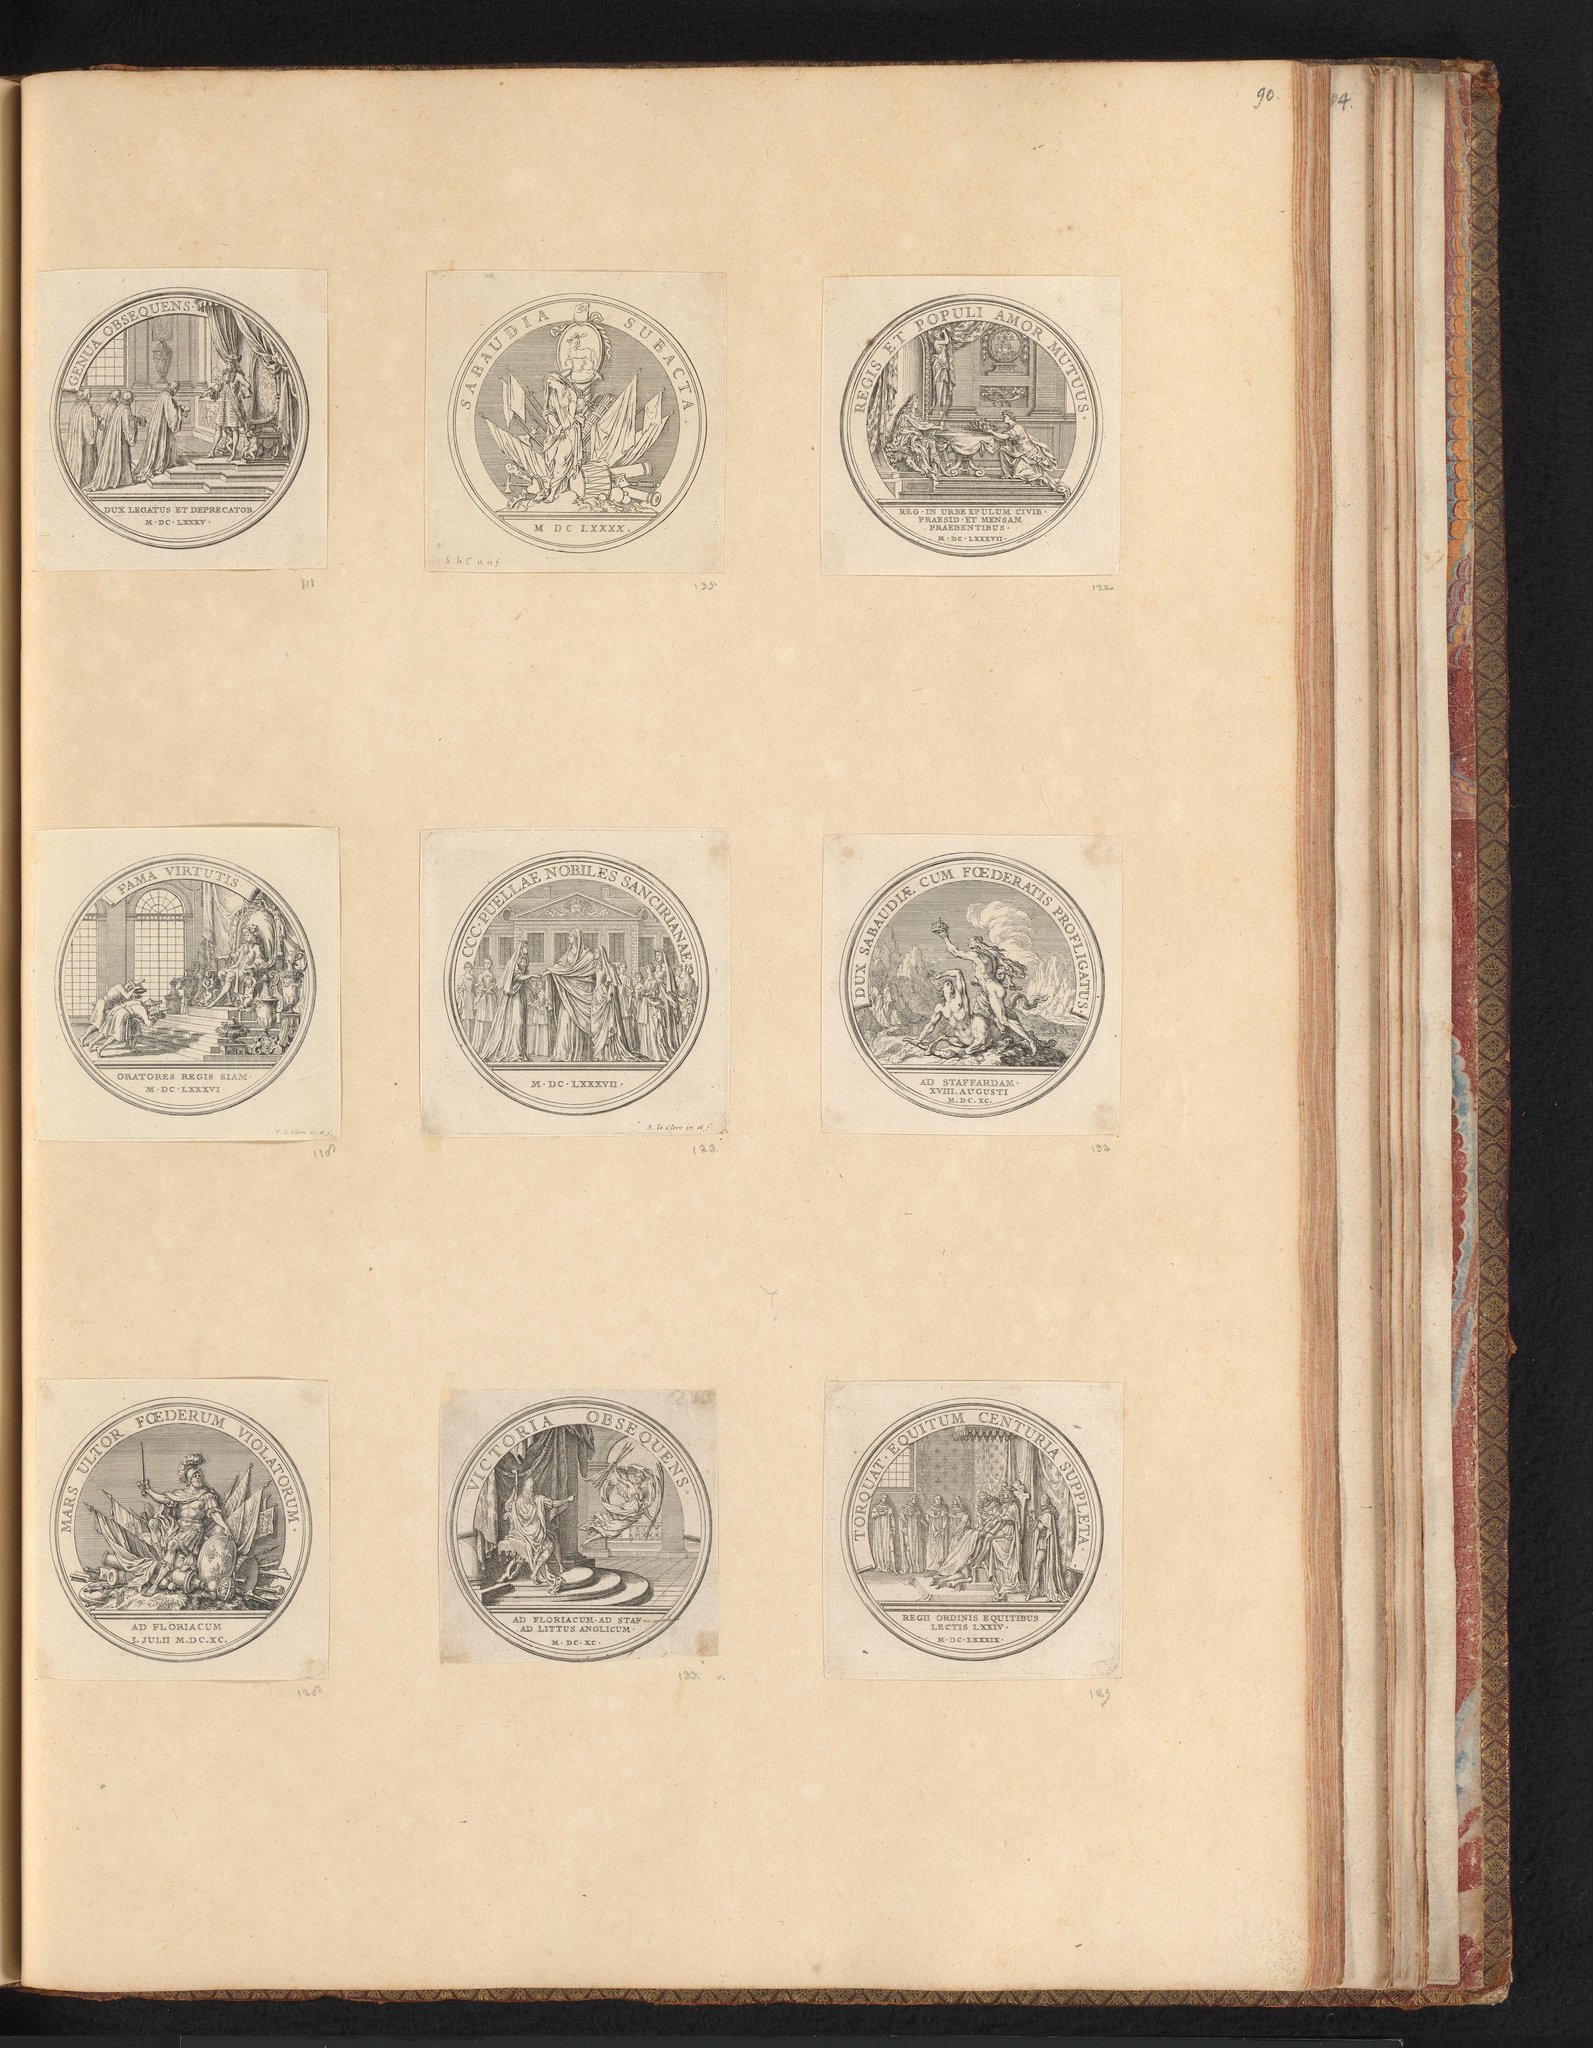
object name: album leaf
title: Negen medailles ter ere van Lodewijk XIV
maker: sébastien leclerc (i)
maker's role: print maker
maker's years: 1637-1714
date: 1702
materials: paper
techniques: etching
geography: paris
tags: lodewijk xiv (koning van frankrijk), historical persons, battle, medal (considered as a piece of sculpture, regardless of its specific function), ambassador, knighthood order of the holy spirit, piety, 'pietas', 'timor dei' ~ the three theological virtues, king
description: Prenten bestemd voor: Médailles sur les principaux événements du règne de Louis le Grand. Parijs: Imprimerie Royale, 1702. Twee prenten niet gepubliceerd.